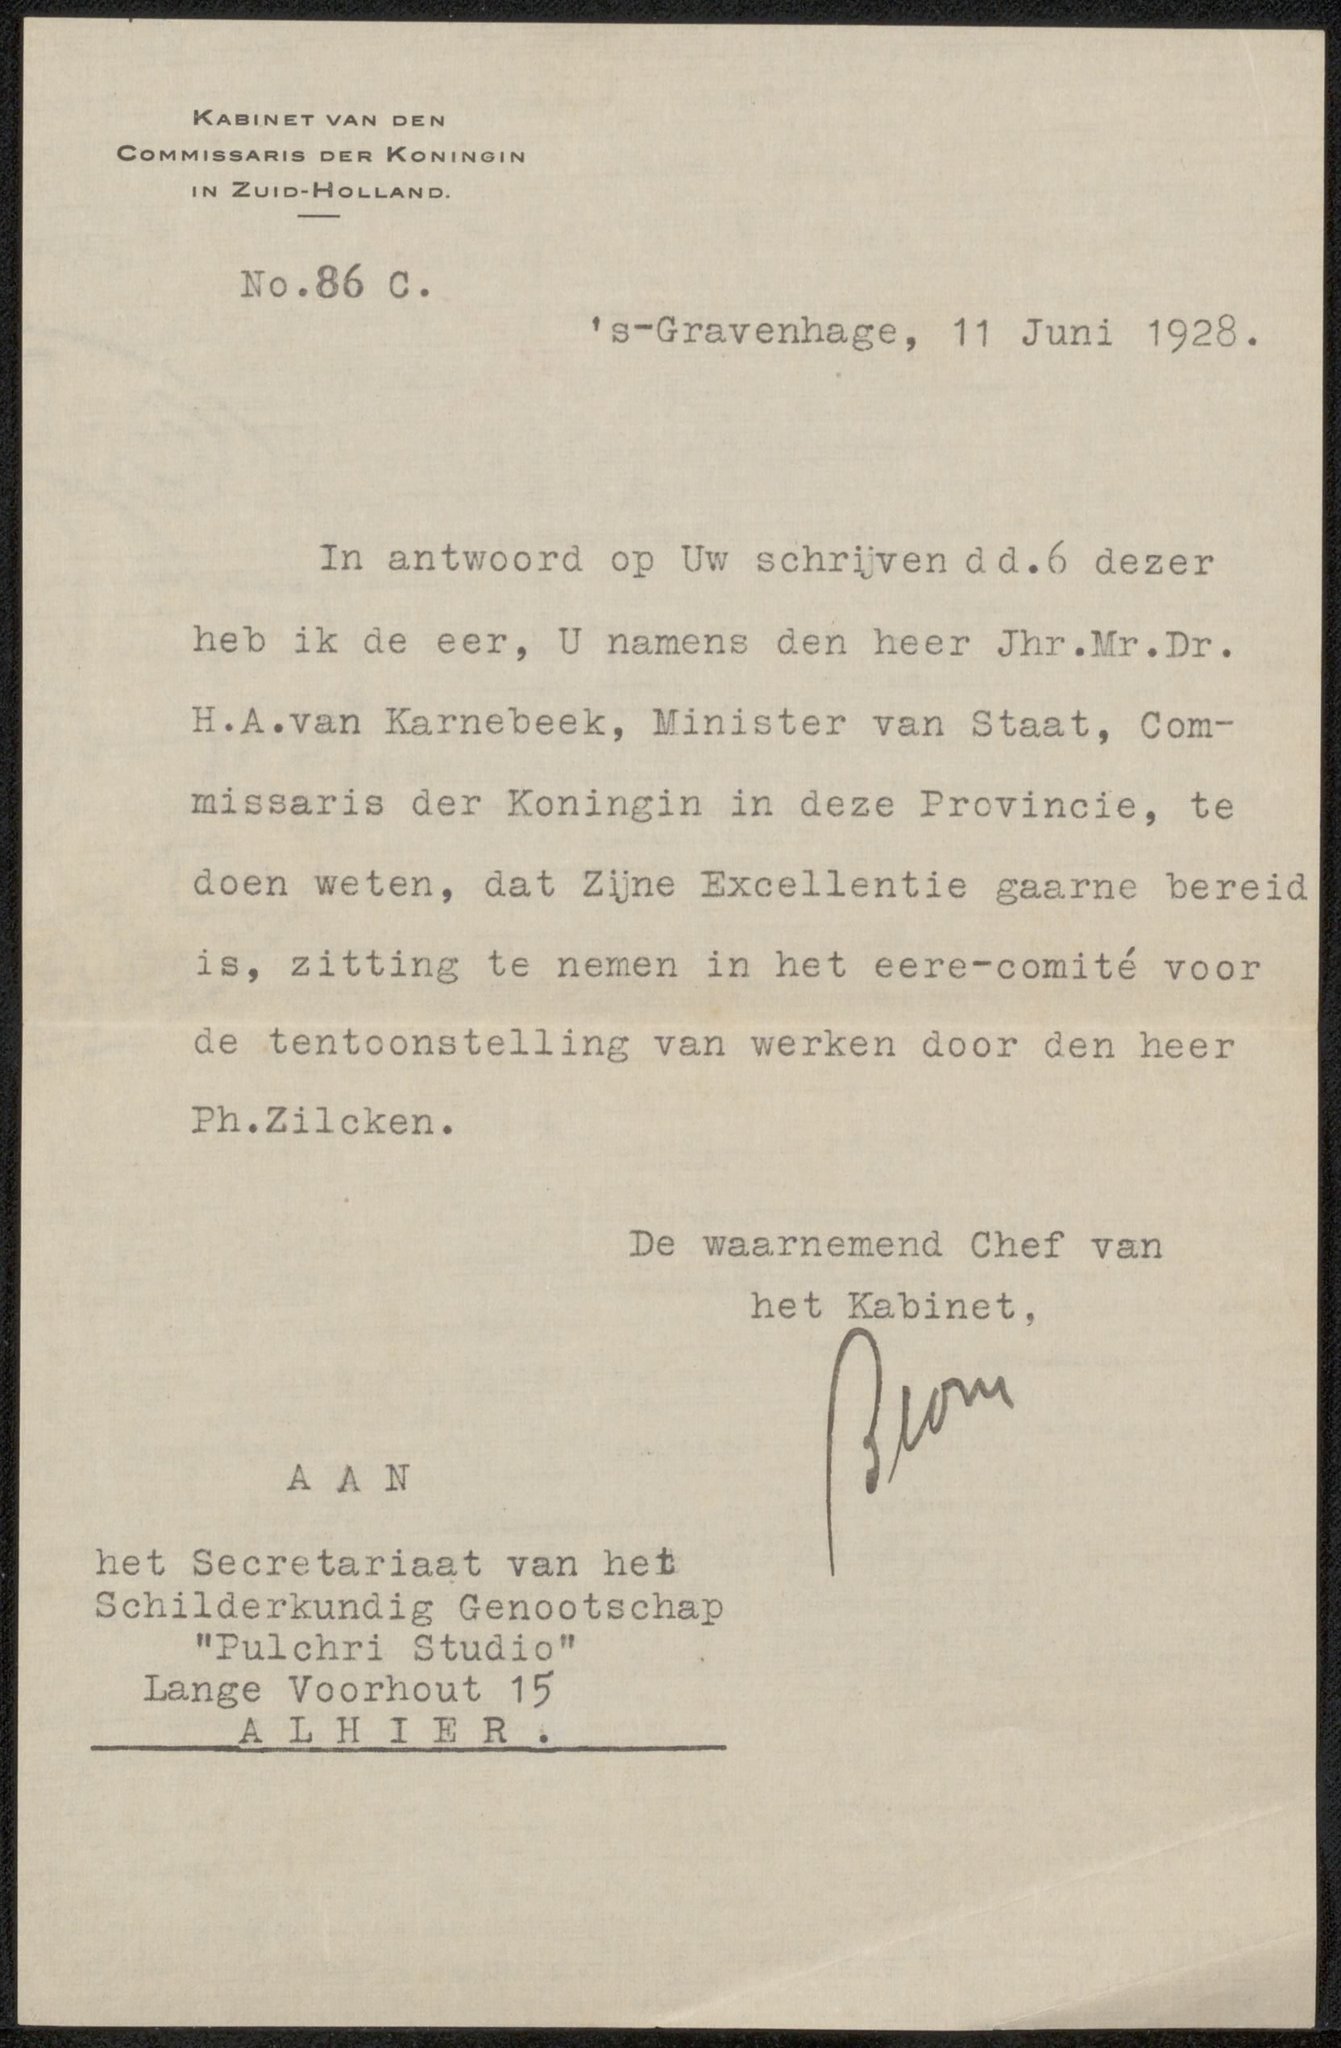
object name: letter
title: Brief aan het secretariaat van Pulchri Studio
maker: Anonymous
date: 1928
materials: ink, paper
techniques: pen, printing, typewriting, writing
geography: the hague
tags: the hague, painter, draughtsman, philip zilcken, exhibition ~ art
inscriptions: watermark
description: Objectnummers RP-D-1982-43-166 tot en met RP-D-1982-43-171 hebben betrekking op een tentoonstelling van werken van Philip Zilcken in Pulchri Studio te Den Haag.